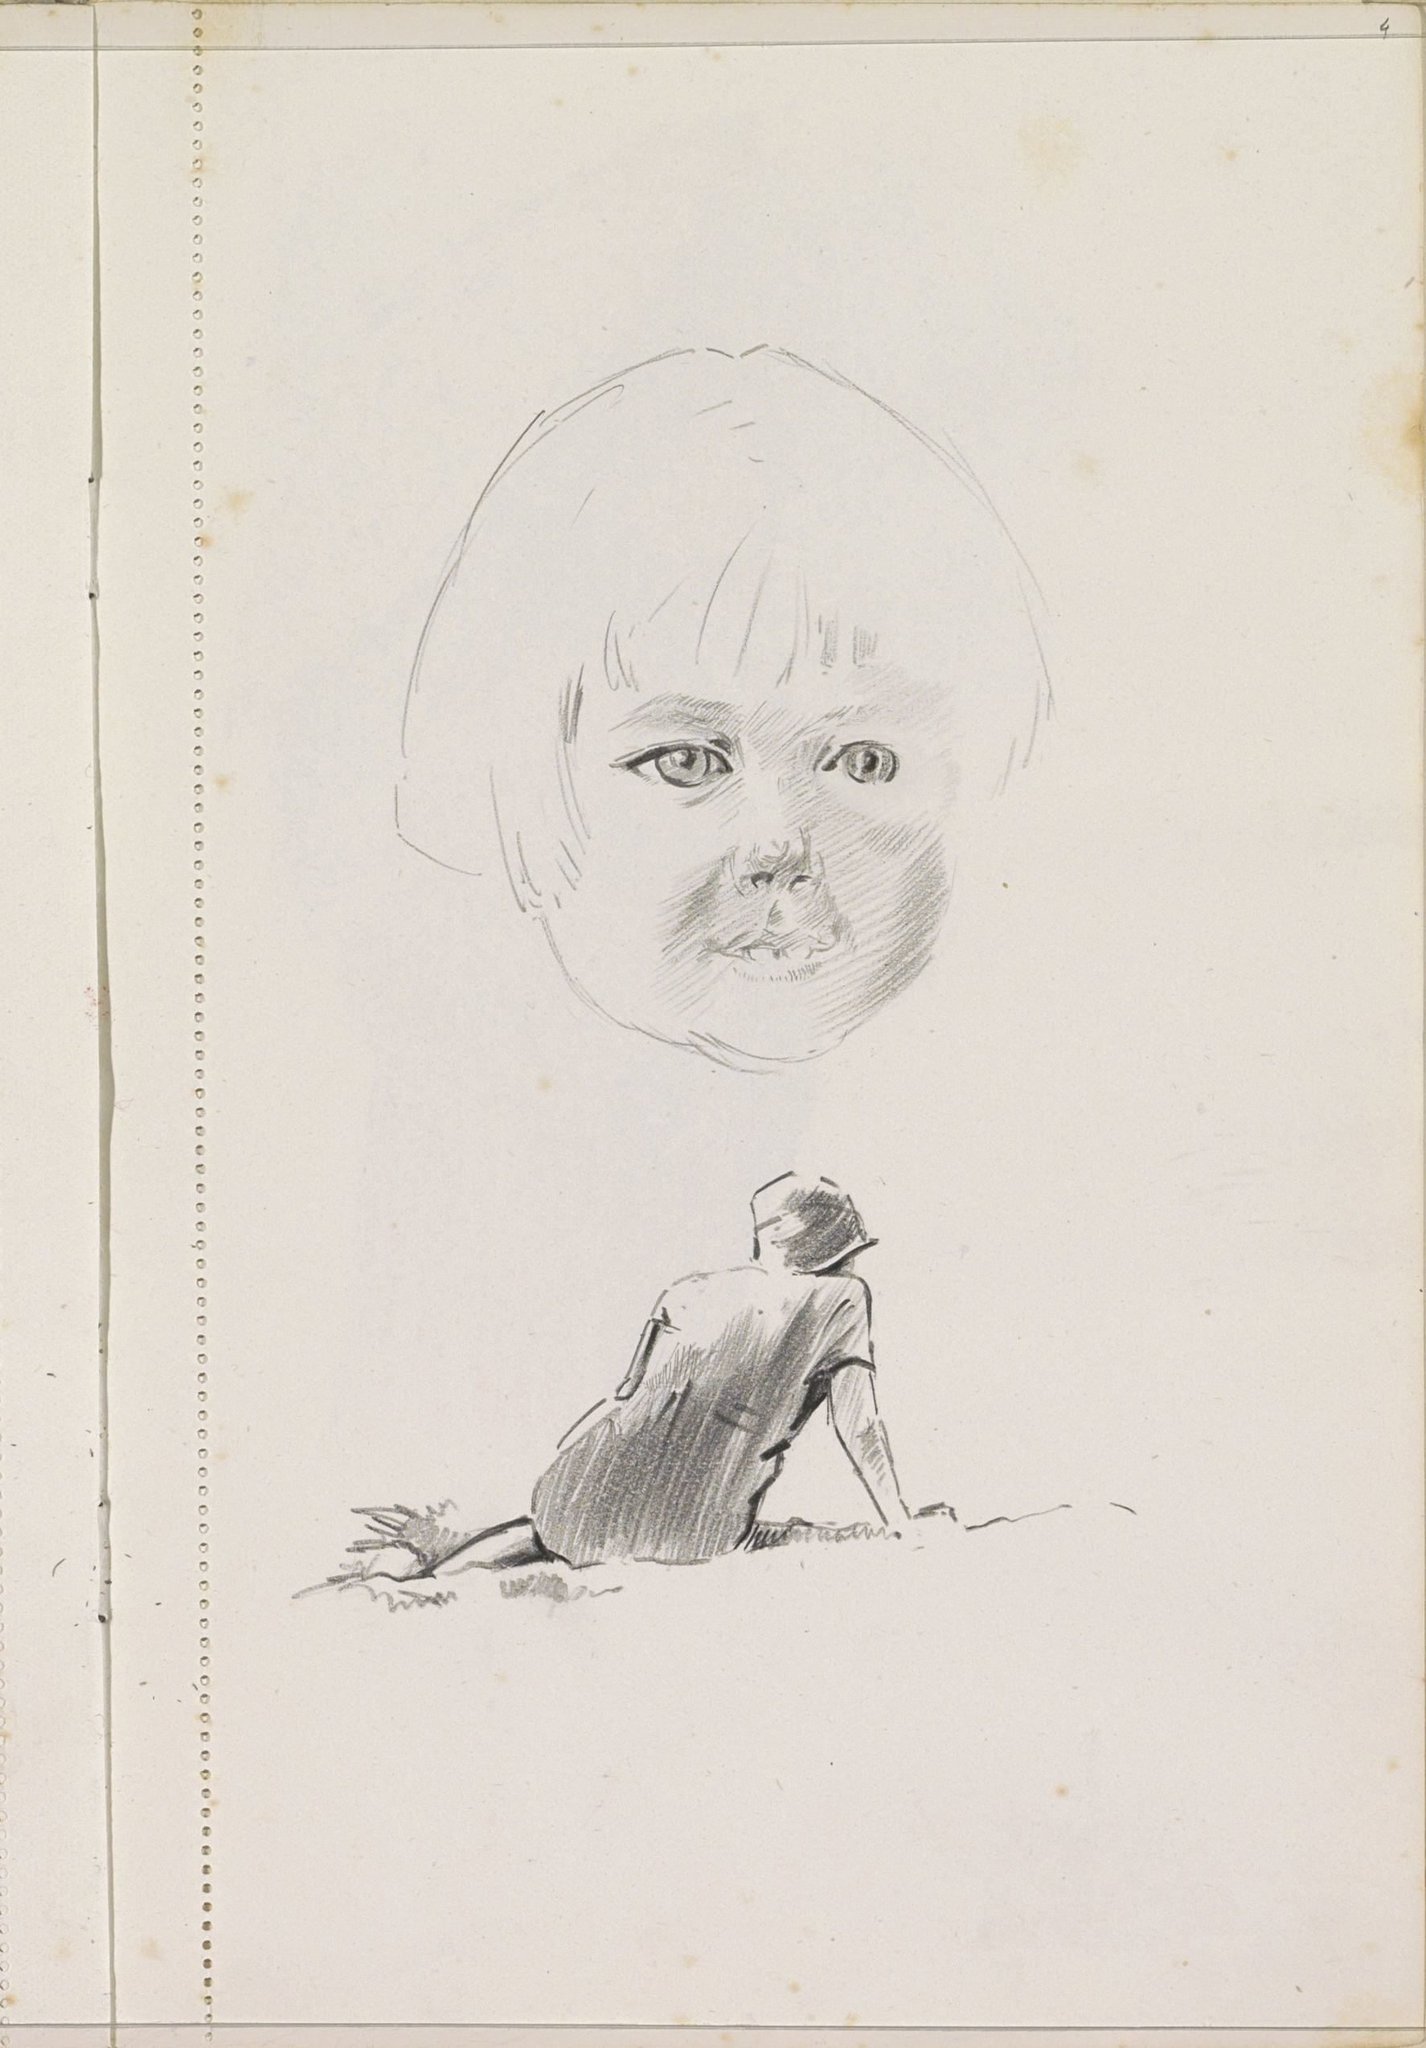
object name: sketchbook leaf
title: Hoofd van een meisje en een vrouw zittend in het gras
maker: otto verhagen (i)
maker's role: draughtsman, print maker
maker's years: 1885-1951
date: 1928-1930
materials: chalk, paper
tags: head (human), sitting figure, girl (child between toddler and youth)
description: De vrouw draagt een hoed en steunt met haar rechterhand op de grond. Pagina 4 uit een schetsboek met 51 bladen.